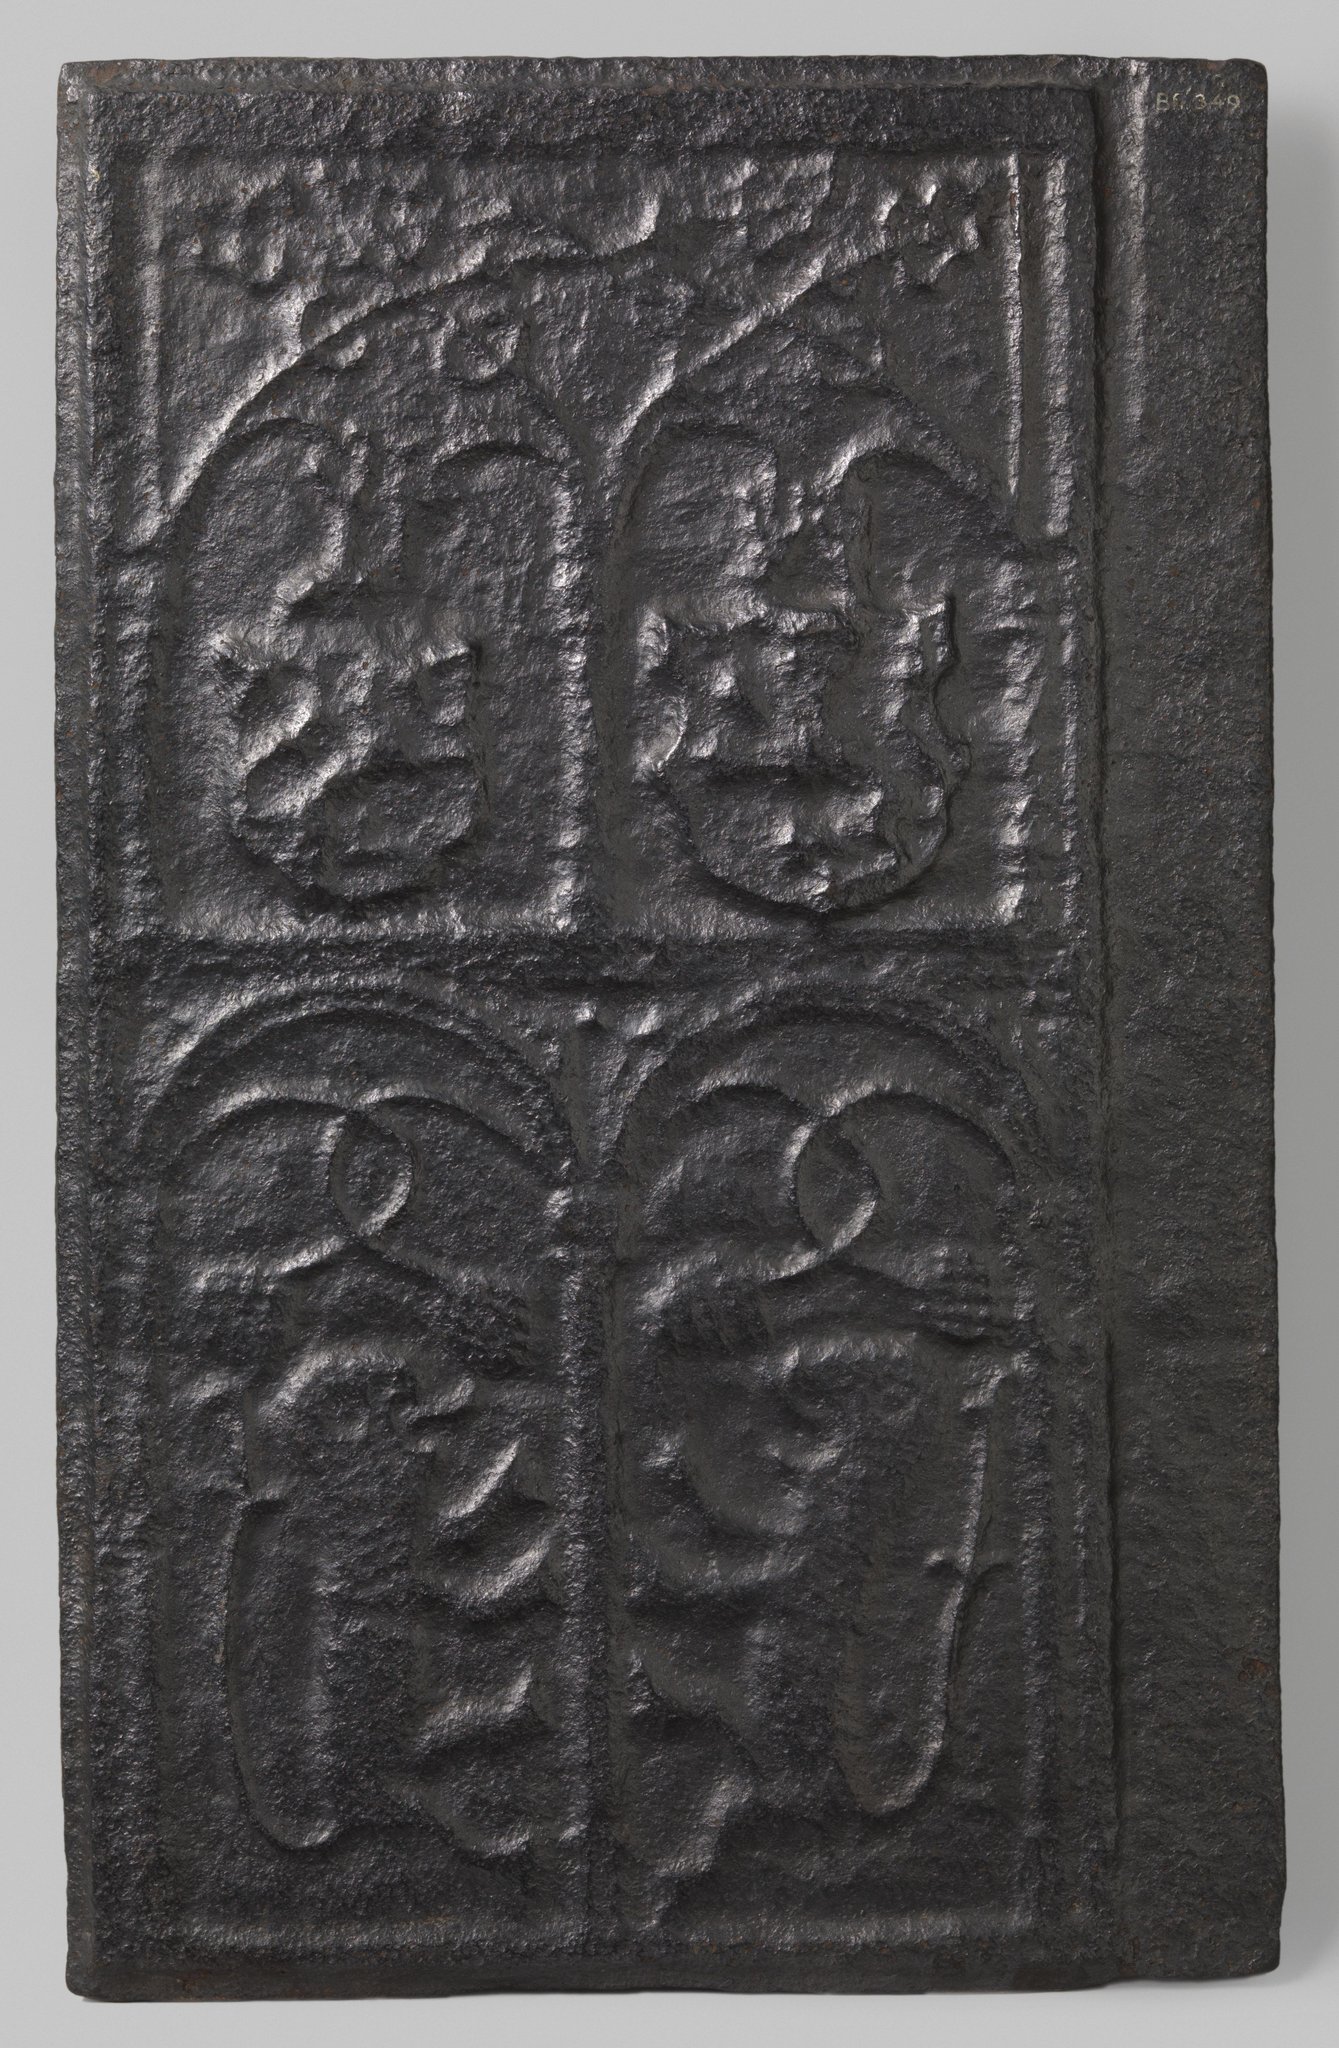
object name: stove plate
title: Kachelplaat met wapenschilden en leeuwen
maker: Anonymous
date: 1475-1525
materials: iron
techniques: casting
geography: germany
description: Kachelplaat van gietijzer, verdeeld in twee zones. In de bovenste zone zijn twee wapenschilden afgebeeld, beide met een staande leeuw. De schilden zijn geplaatst tussen drie zuilen, waarop twee dubbele bogen rusten met daarboven rankwerk. In de onderste helft twee staande leeuwen onder een ronde boog, van elkaar gescheiden door een zuil. Boven de leeuw hangen twee druiventrossen.